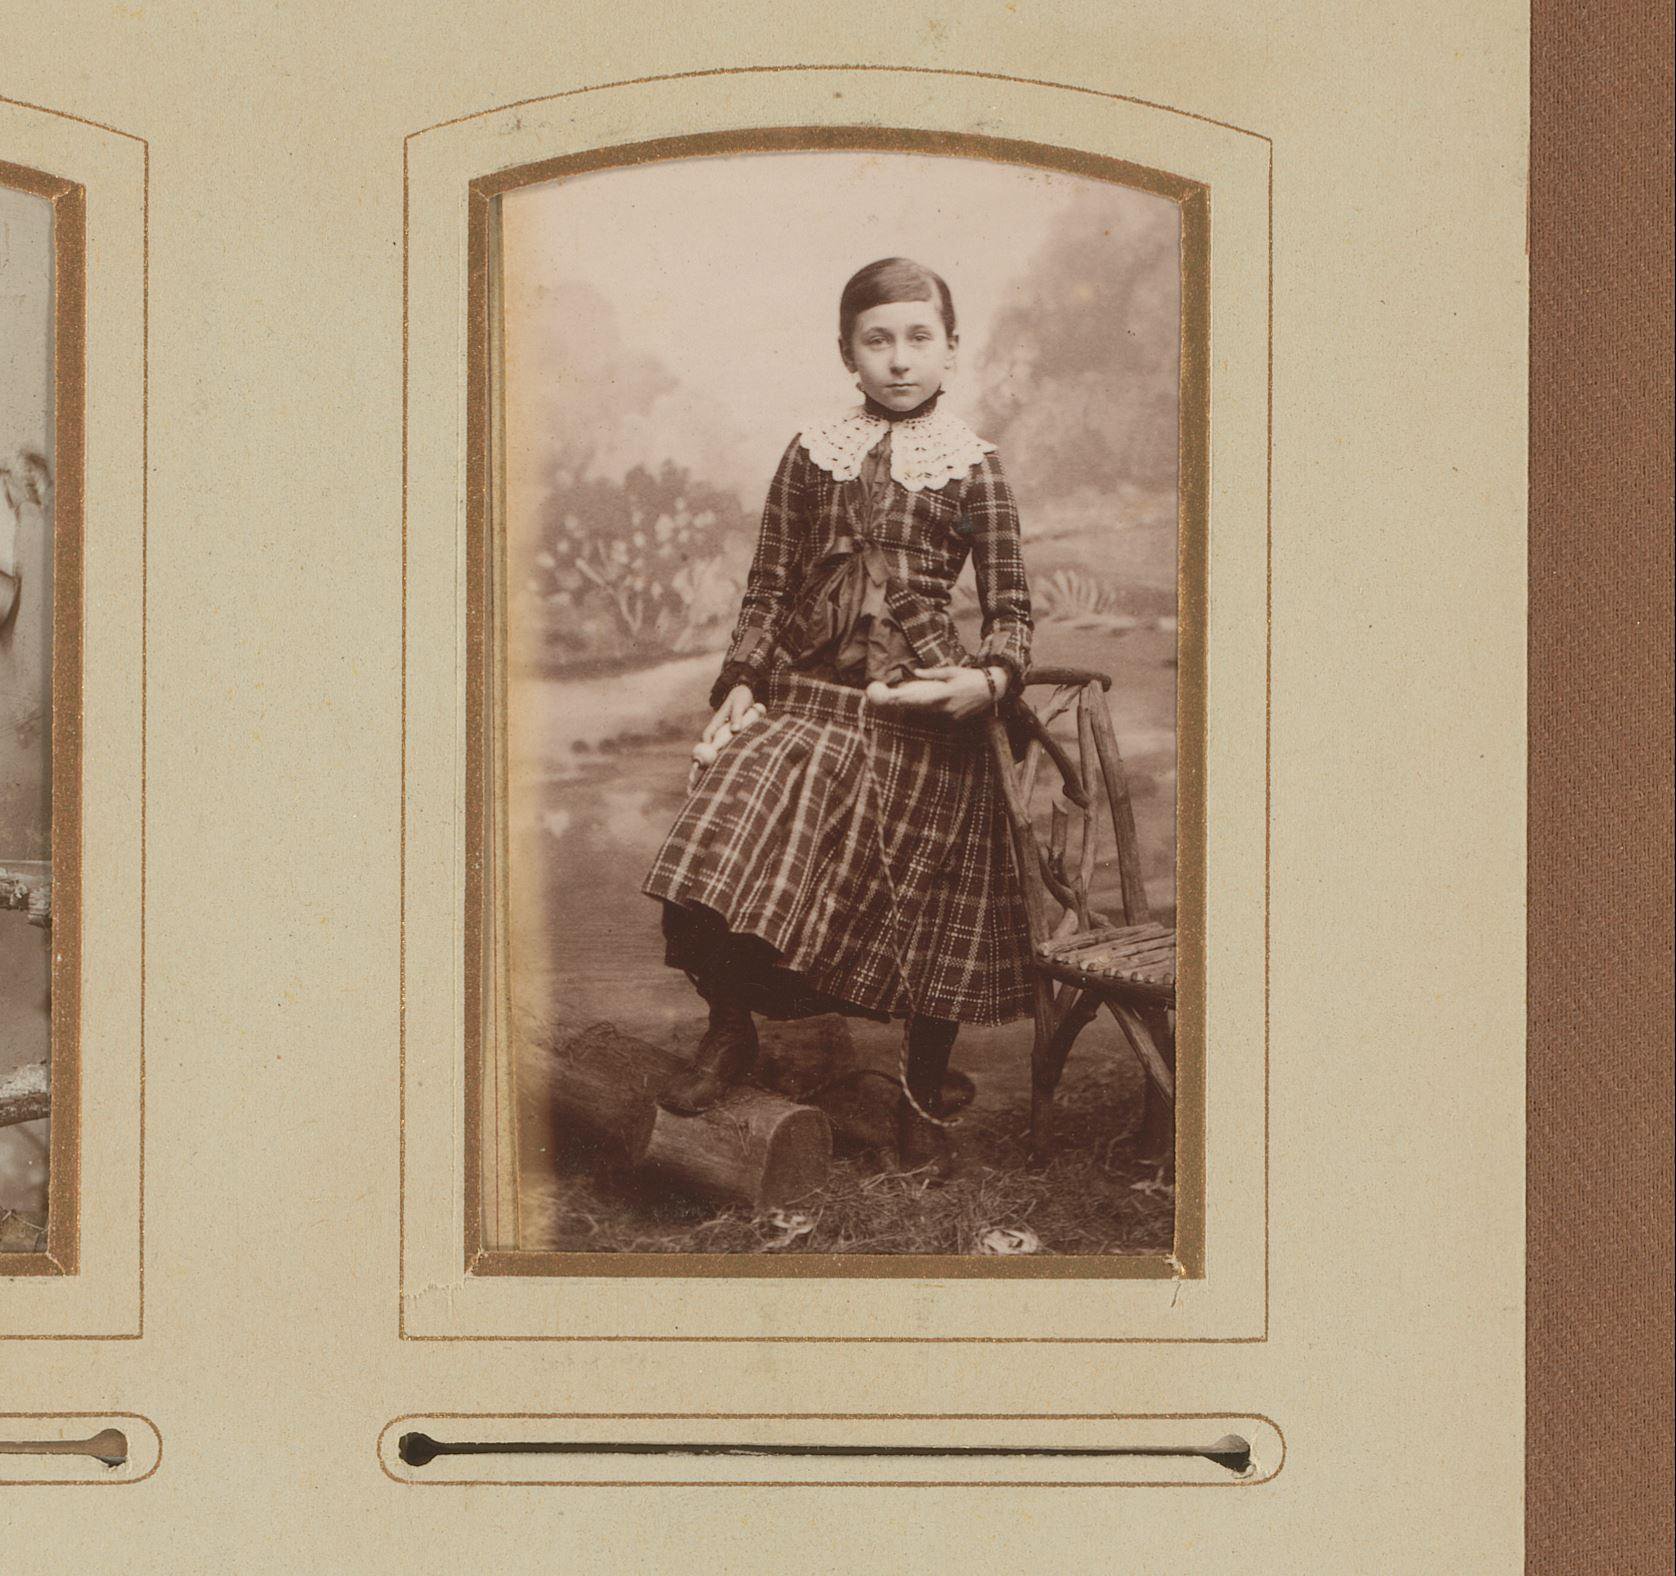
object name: album leaf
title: Portret van een meisje staand bij een stoel met een voet op een boomstam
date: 1882-1894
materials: cardboard, celluloid, photographic support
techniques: albumen print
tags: historical persons - bb - woman, girl (child between toddler and youth), chair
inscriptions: inscription: ‘Photografische Inrigting/ van/ Jacques Chits/ Haarlem/ Waaigat/ No. 14./ Amsterdam/ Plantage/ Kerklaan No. 15/ over de Koningskroon./ De plaat blijft ter nabestelling bewaard.’